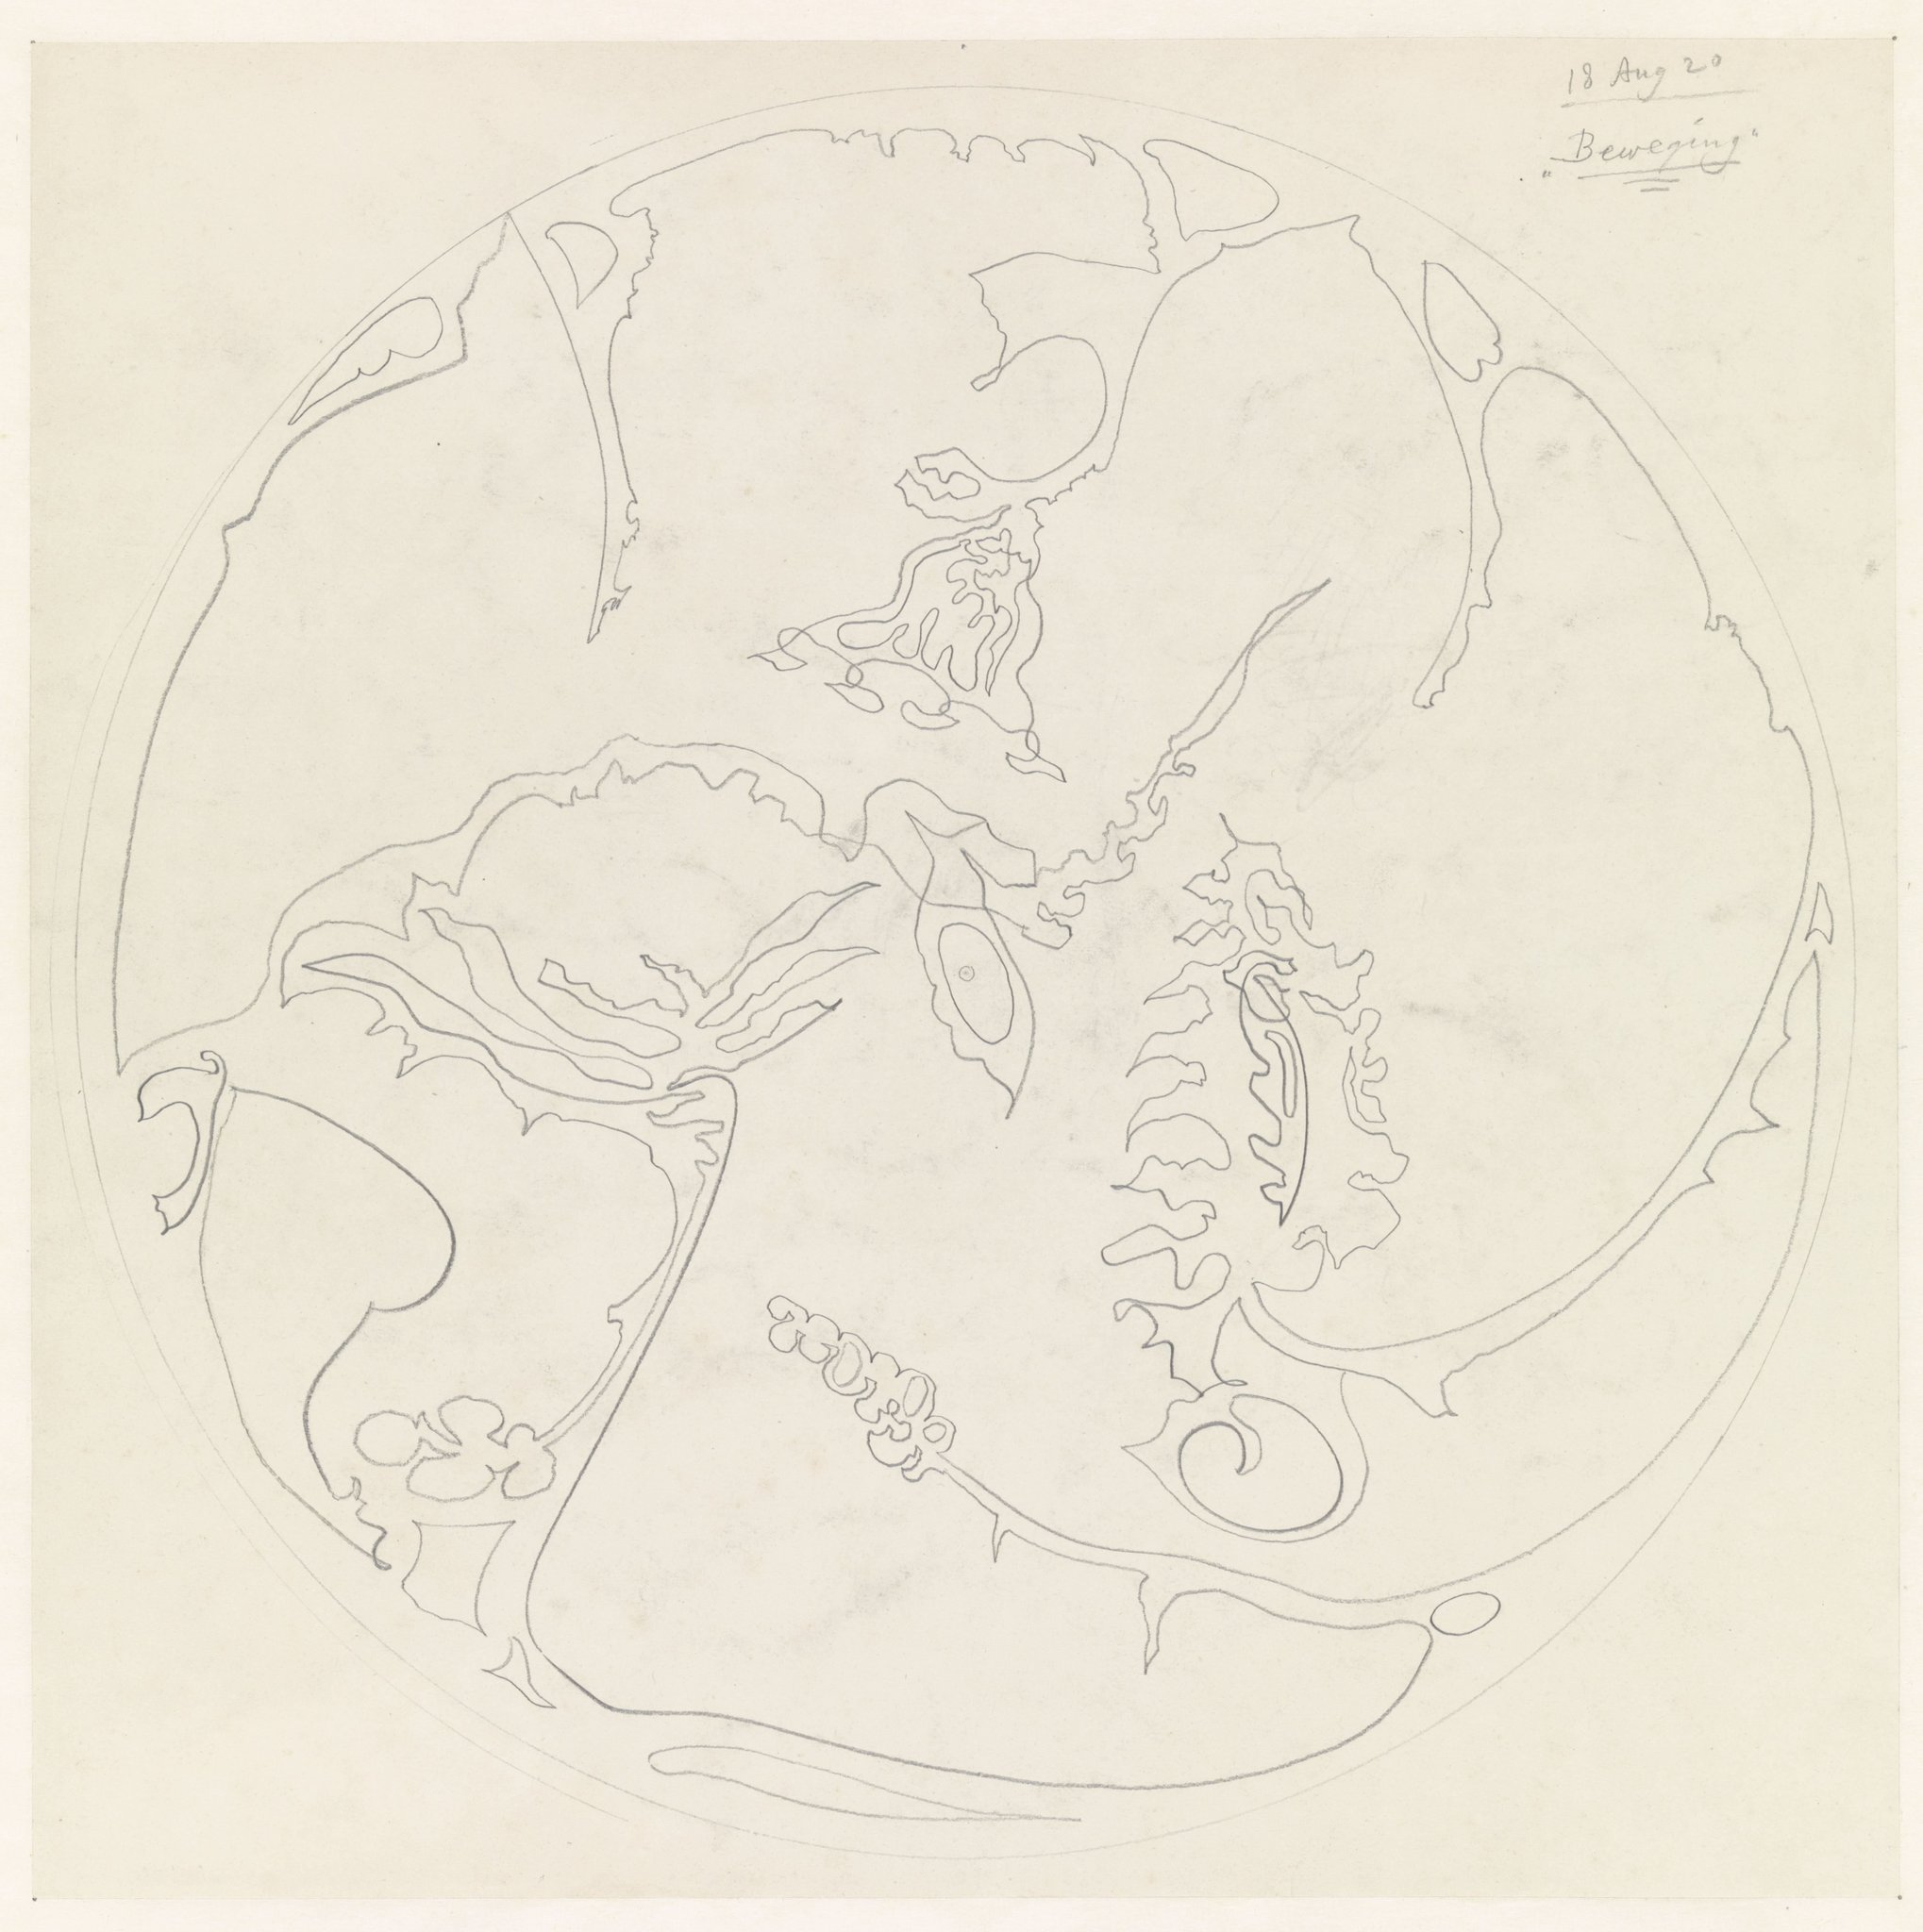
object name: drawing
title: Beweging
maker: theo colenbrander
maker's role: draughtsman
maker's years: 1841-1930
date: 1920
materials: paper, pencil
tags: (other) historical names, ornament derived from plant forms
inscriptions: date: ‘18 Aug 20’